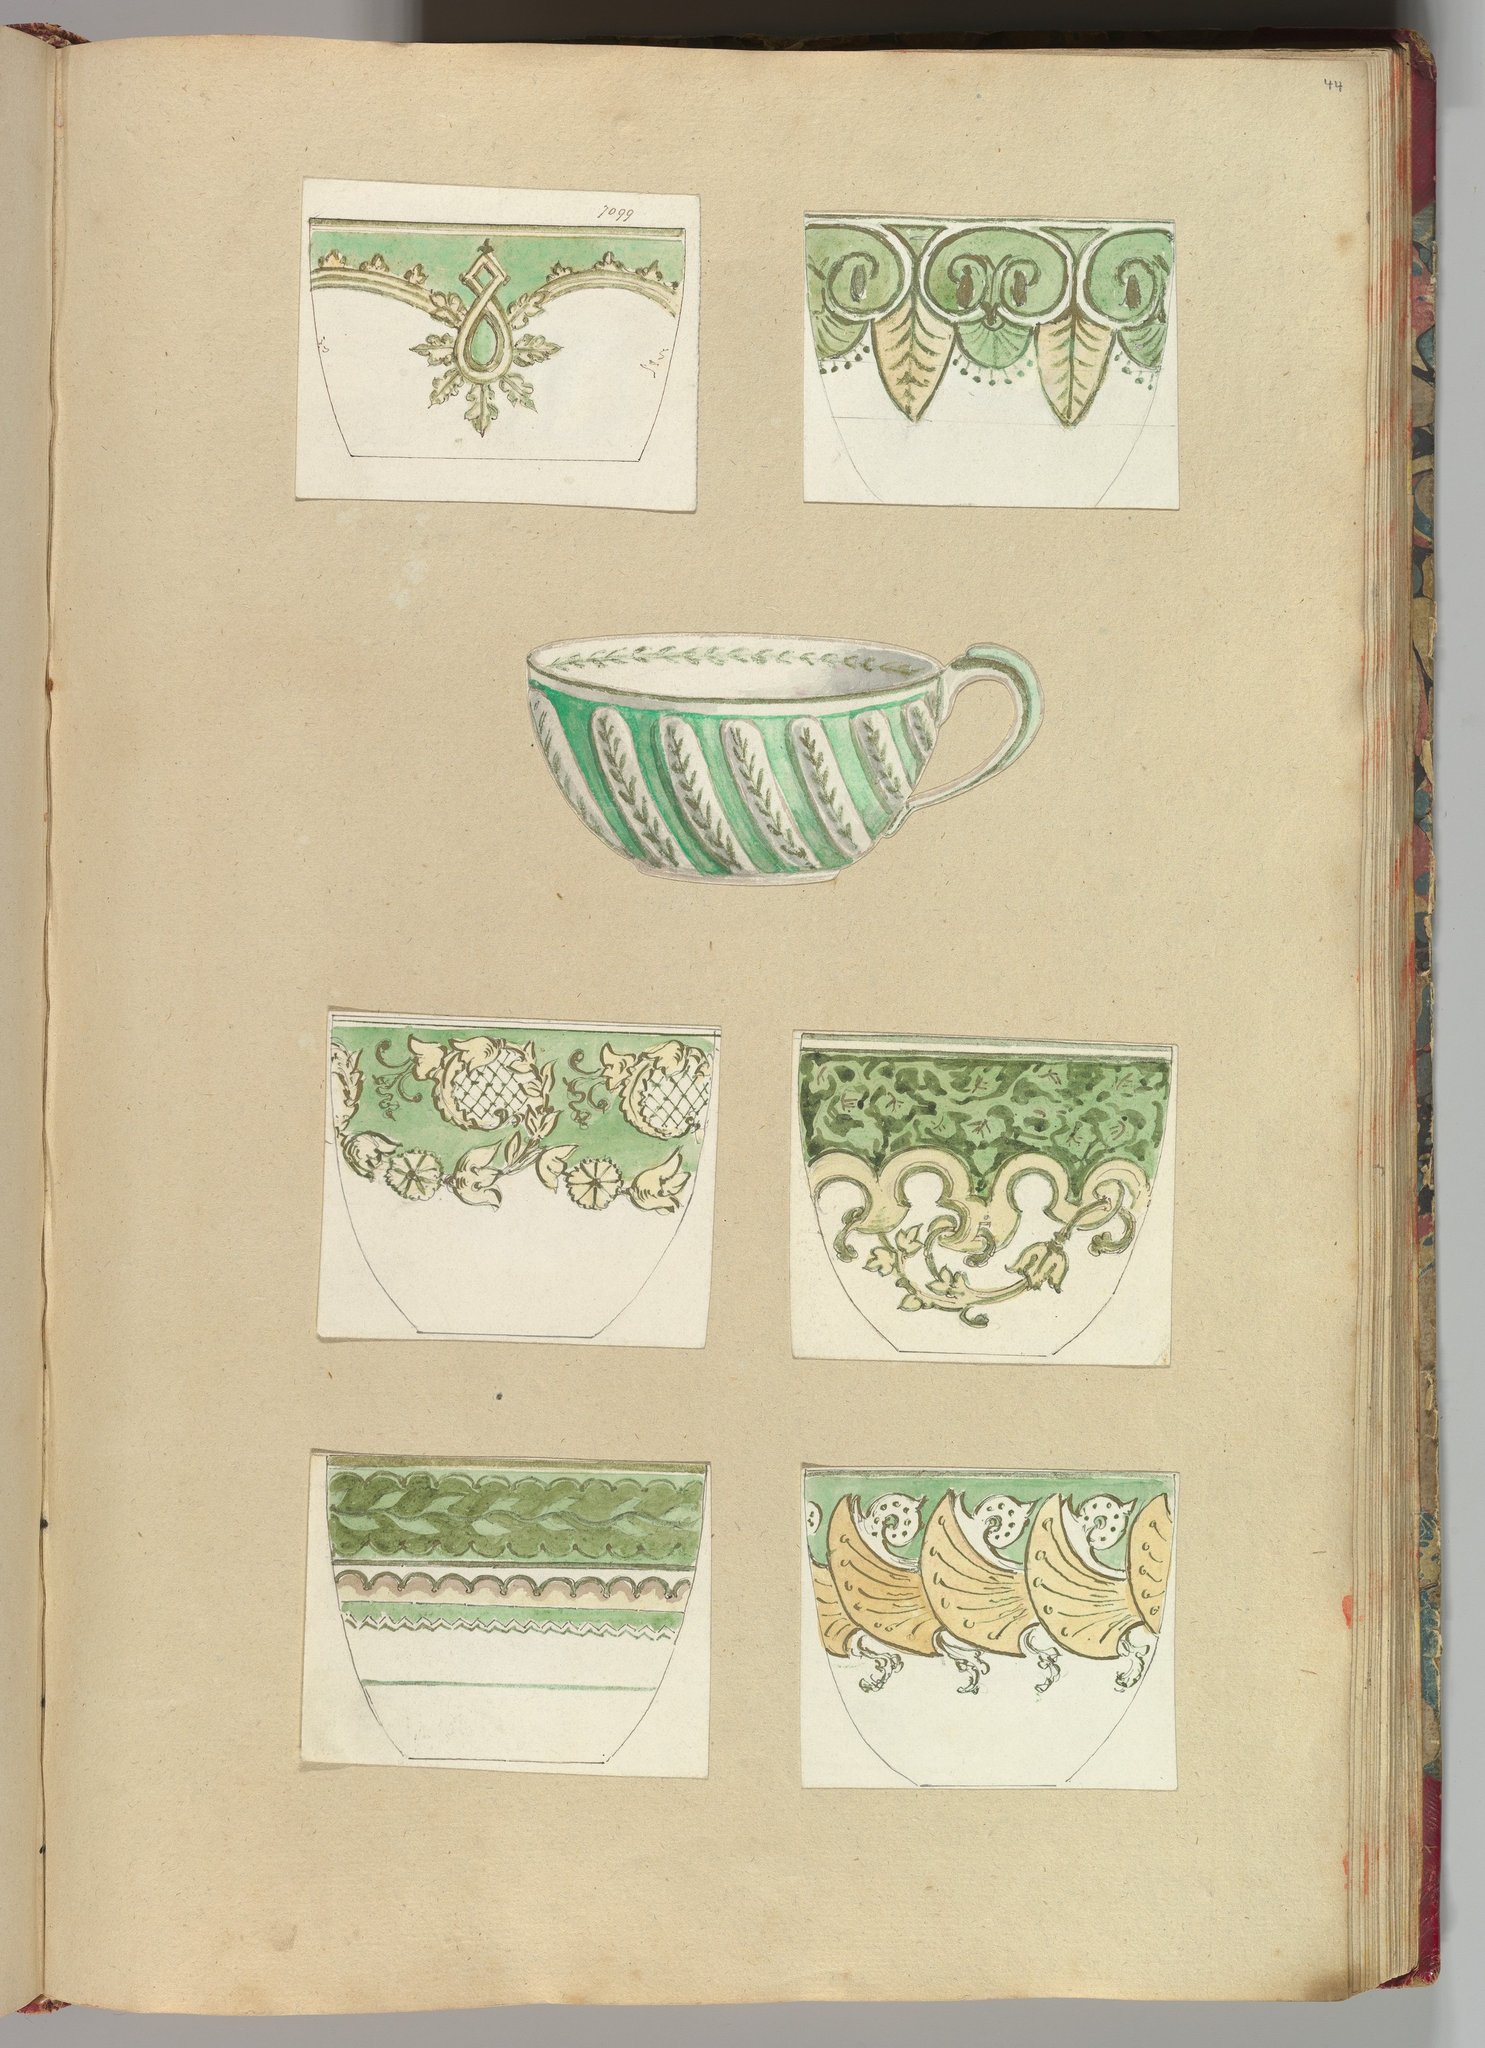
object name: drawing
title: Seven Designs for Decorated Cups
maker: alfred henry forrester [alfred crowquill]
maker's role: artist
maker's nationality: british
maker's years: 1804-1872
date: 1845-1855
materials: ink, watercolor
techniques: pen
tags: cups